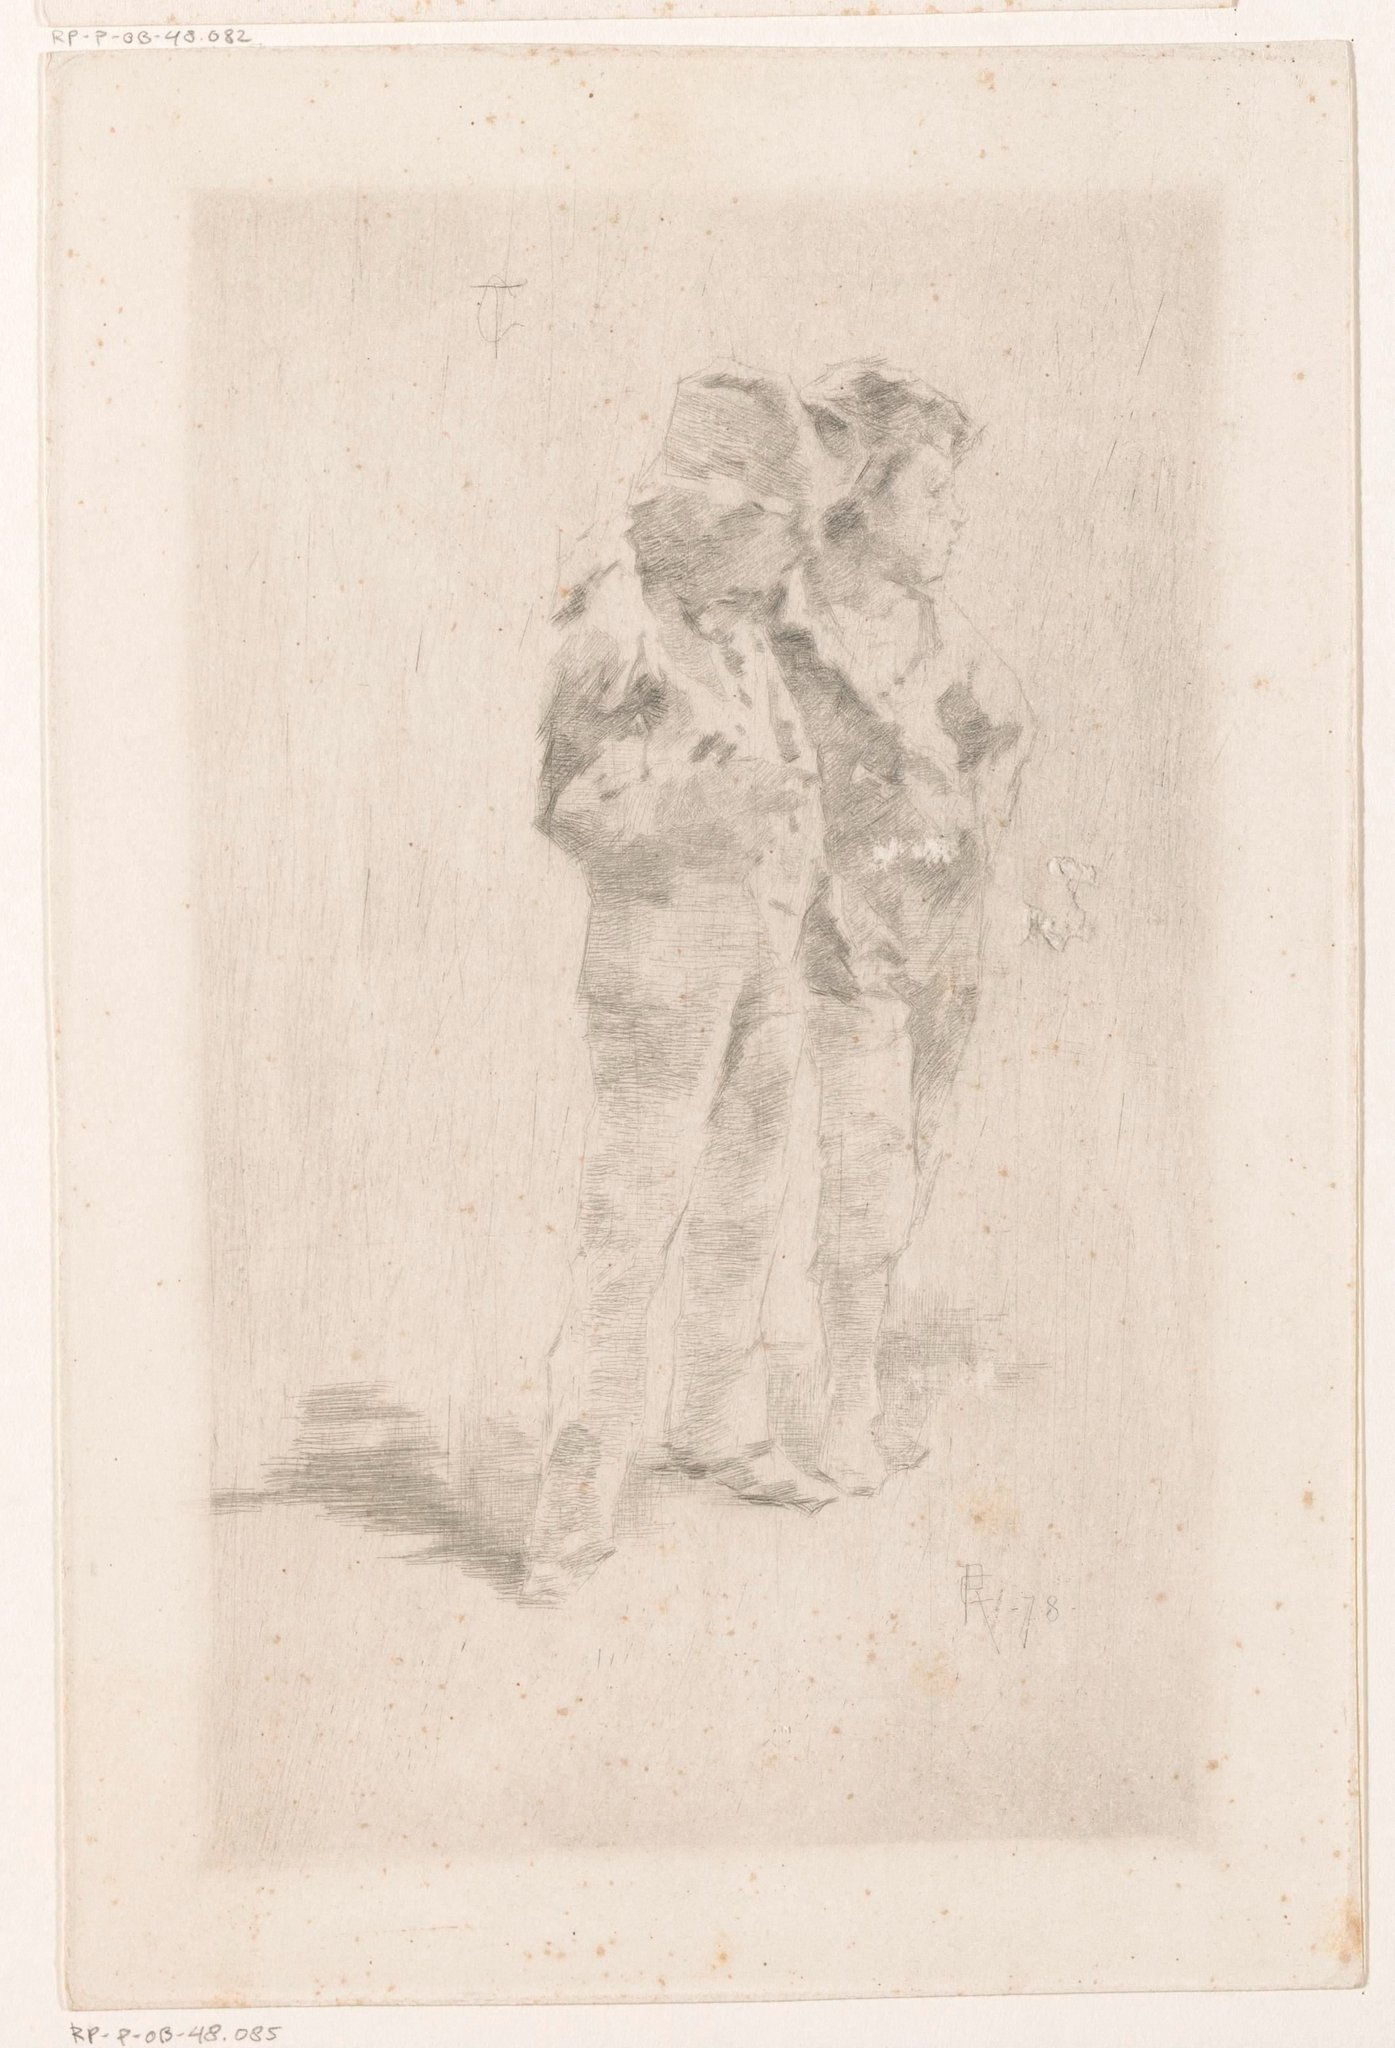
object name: print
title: Twee staande jongens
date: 1878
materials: paper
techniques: etching, intaglio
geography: spain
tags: standing figure, boy (child between toddler and youth)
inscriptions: collector's mark: Lugt 2228